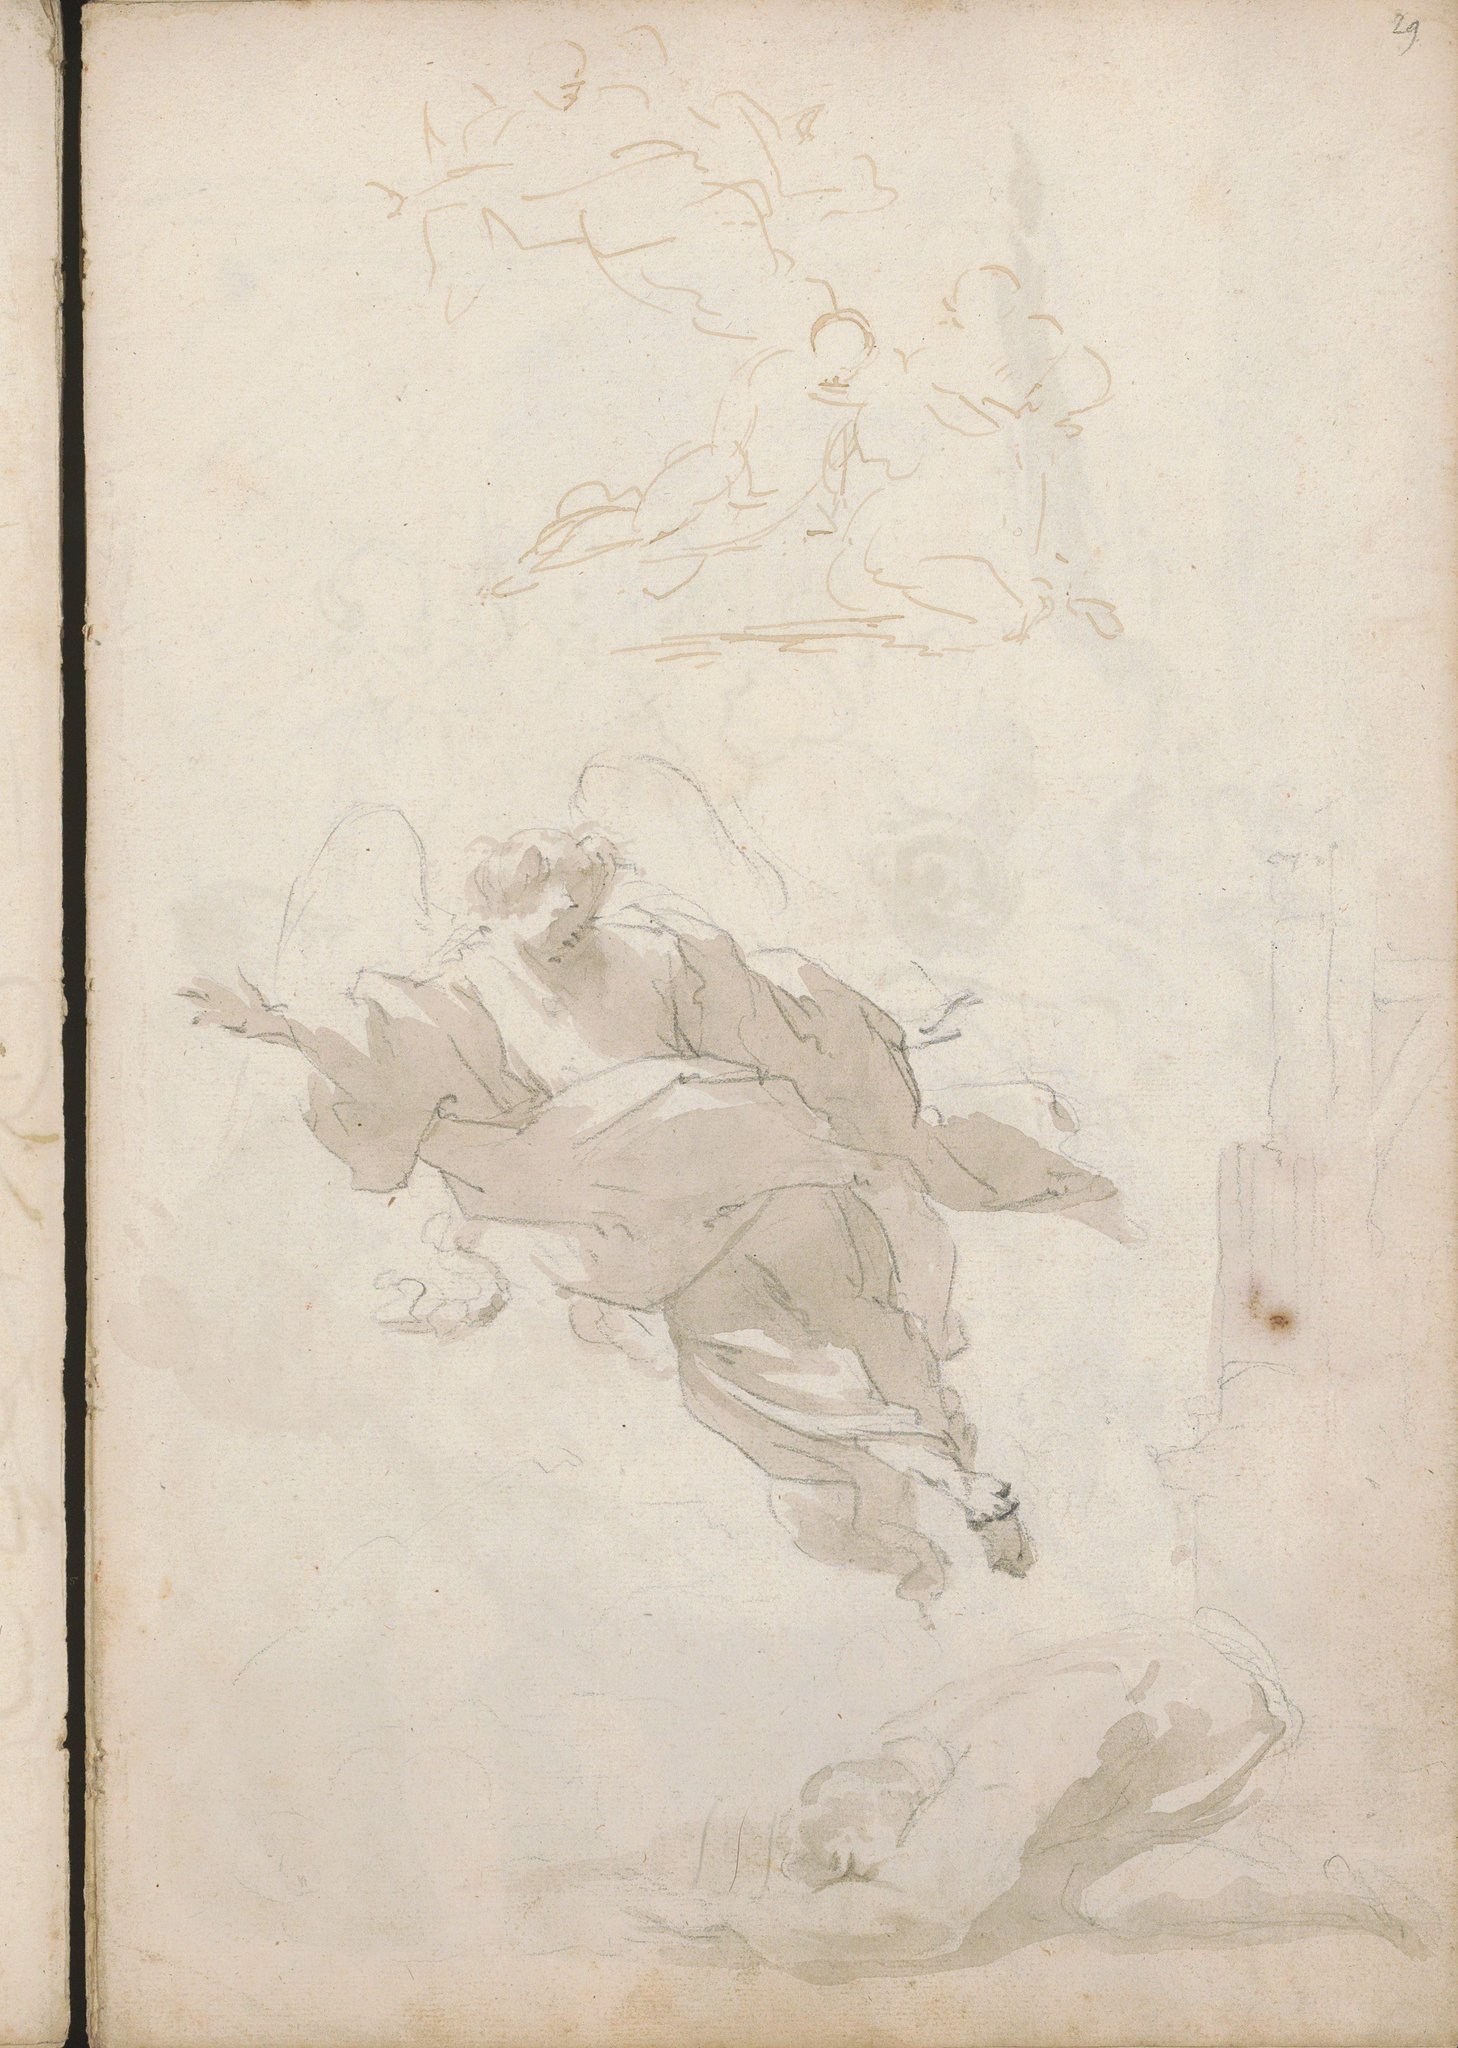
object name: sketchbook leaf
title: Engel vliegend boven een knielende man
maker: Anonymous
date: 1650-1799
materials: ink, paper, pencil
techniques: brush, pen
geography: italy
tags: angels, kneeling on both knees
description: Bladzijde 29 uit een schetsboek met 72 bladzijden.